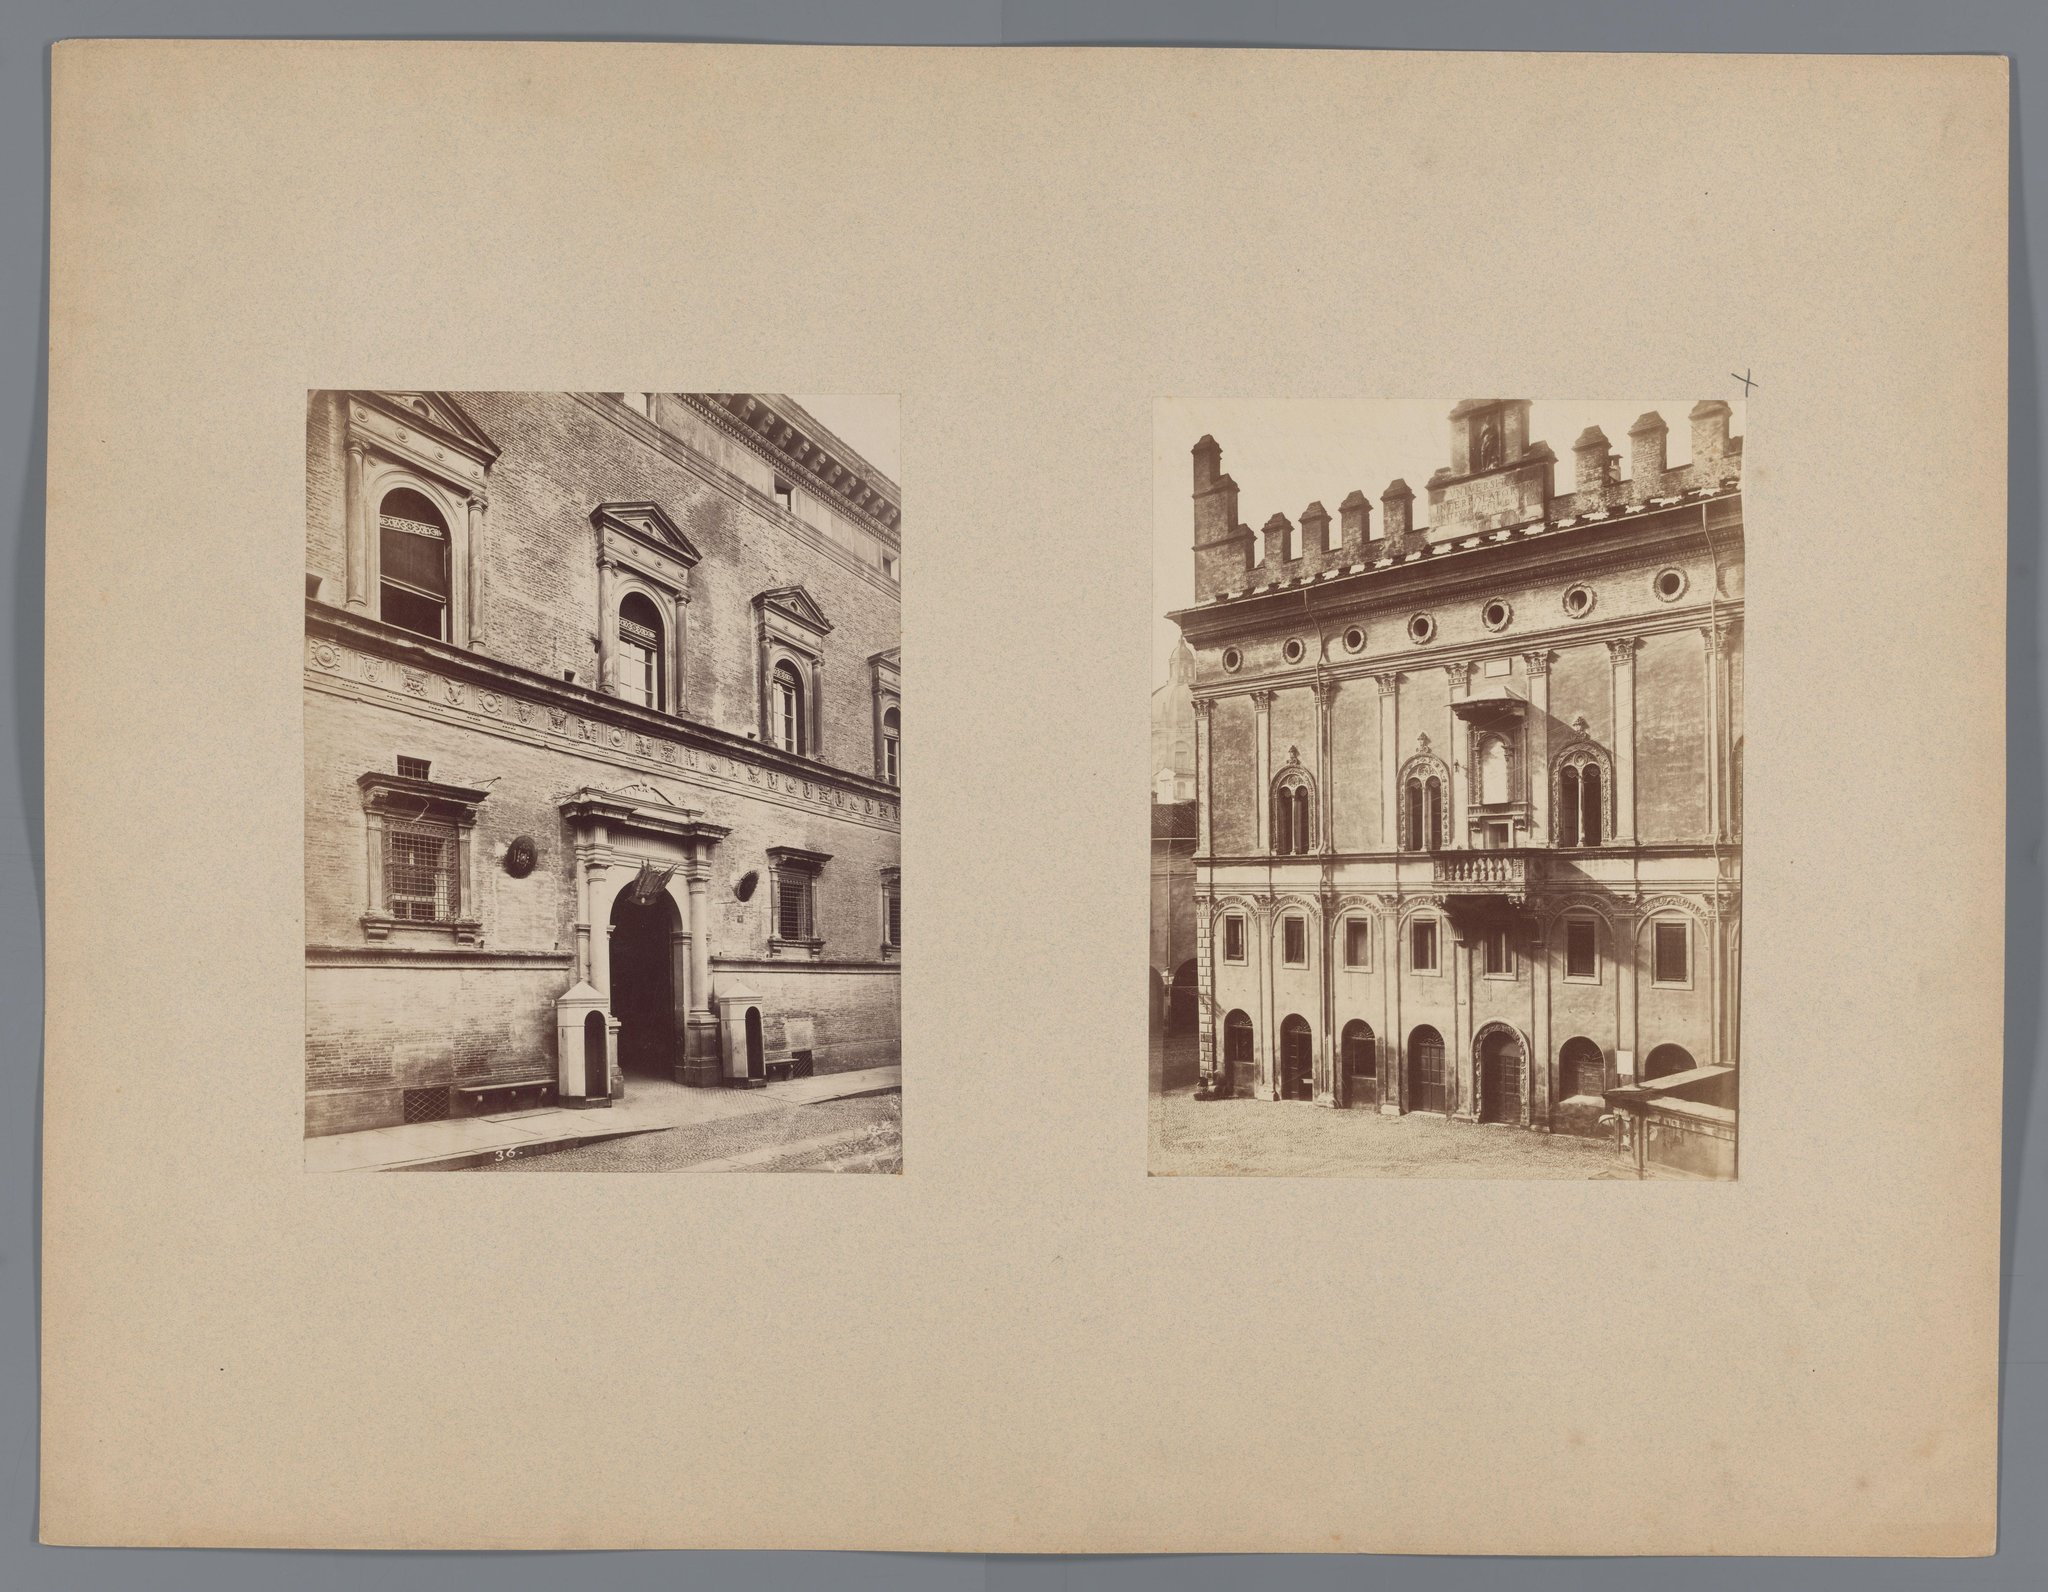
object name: photograph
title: Gezicht op een palazzo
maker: Anonymous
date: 1865-1900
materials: cardboard, photographic support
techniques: albumen print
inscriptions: number: ‘36’